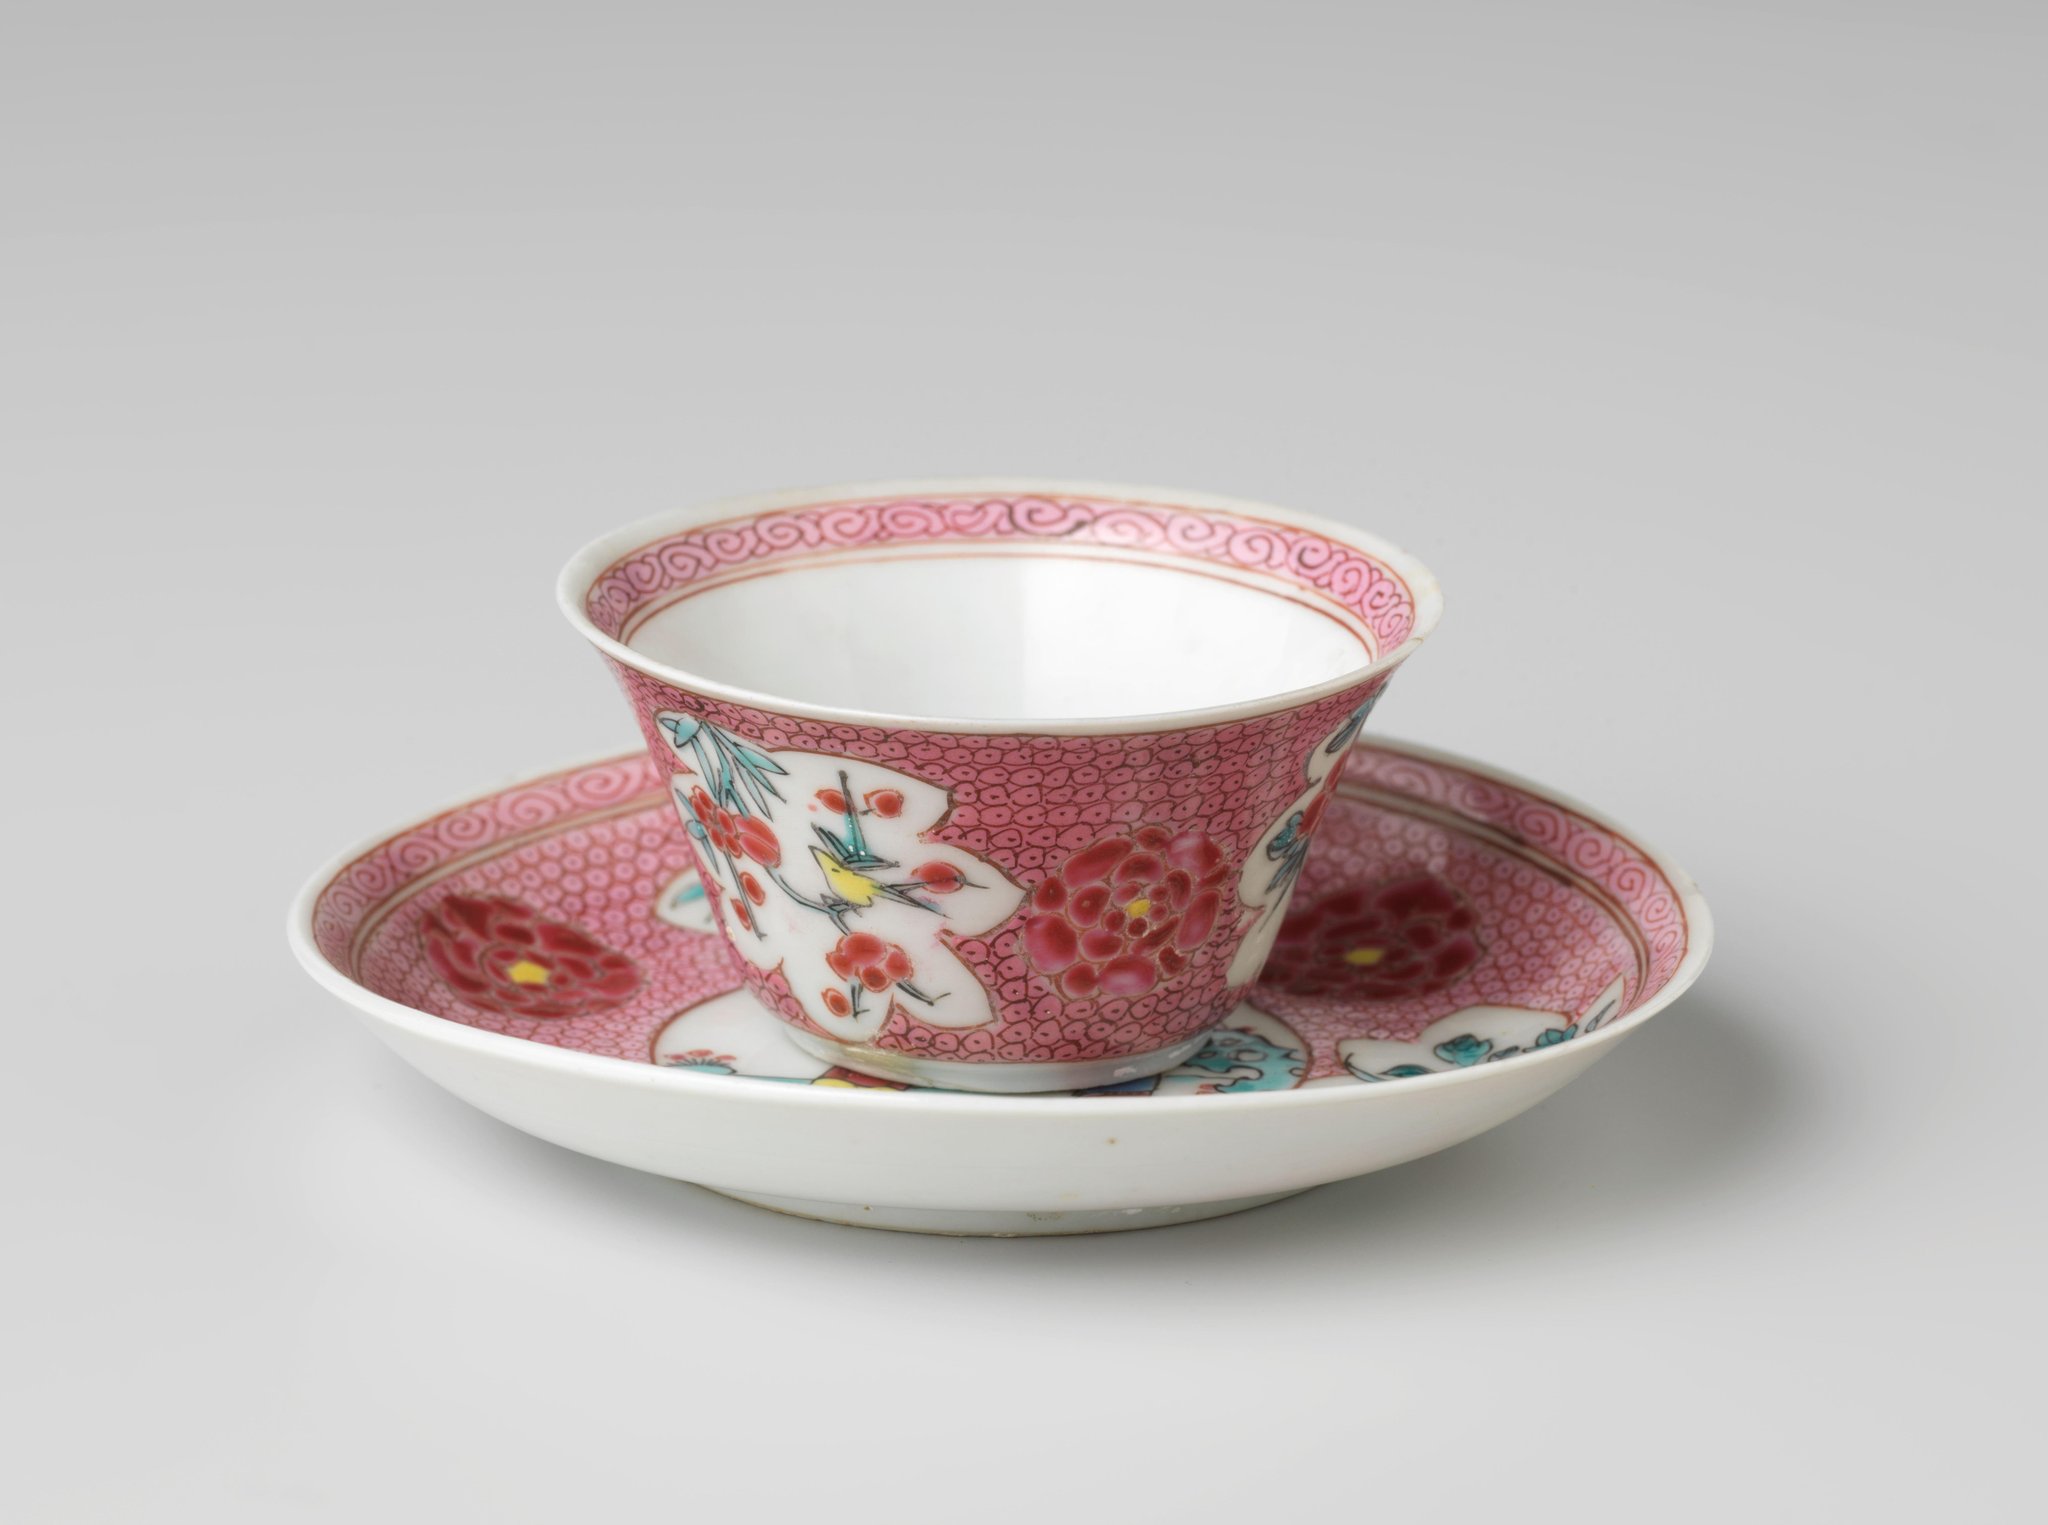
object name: kop en schotel, kop en schotel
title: Cup and saucer with a woman and boy in a landscape and flower sprays on diaper-pattern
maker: Anonymous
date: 1725-1749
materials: glaze, gold, paint, porcelain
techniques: firing, gilding, turning, vitrification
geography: china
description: Kop en schotel, famille rose, versierd met vrouw en kind spelend met een konijn.